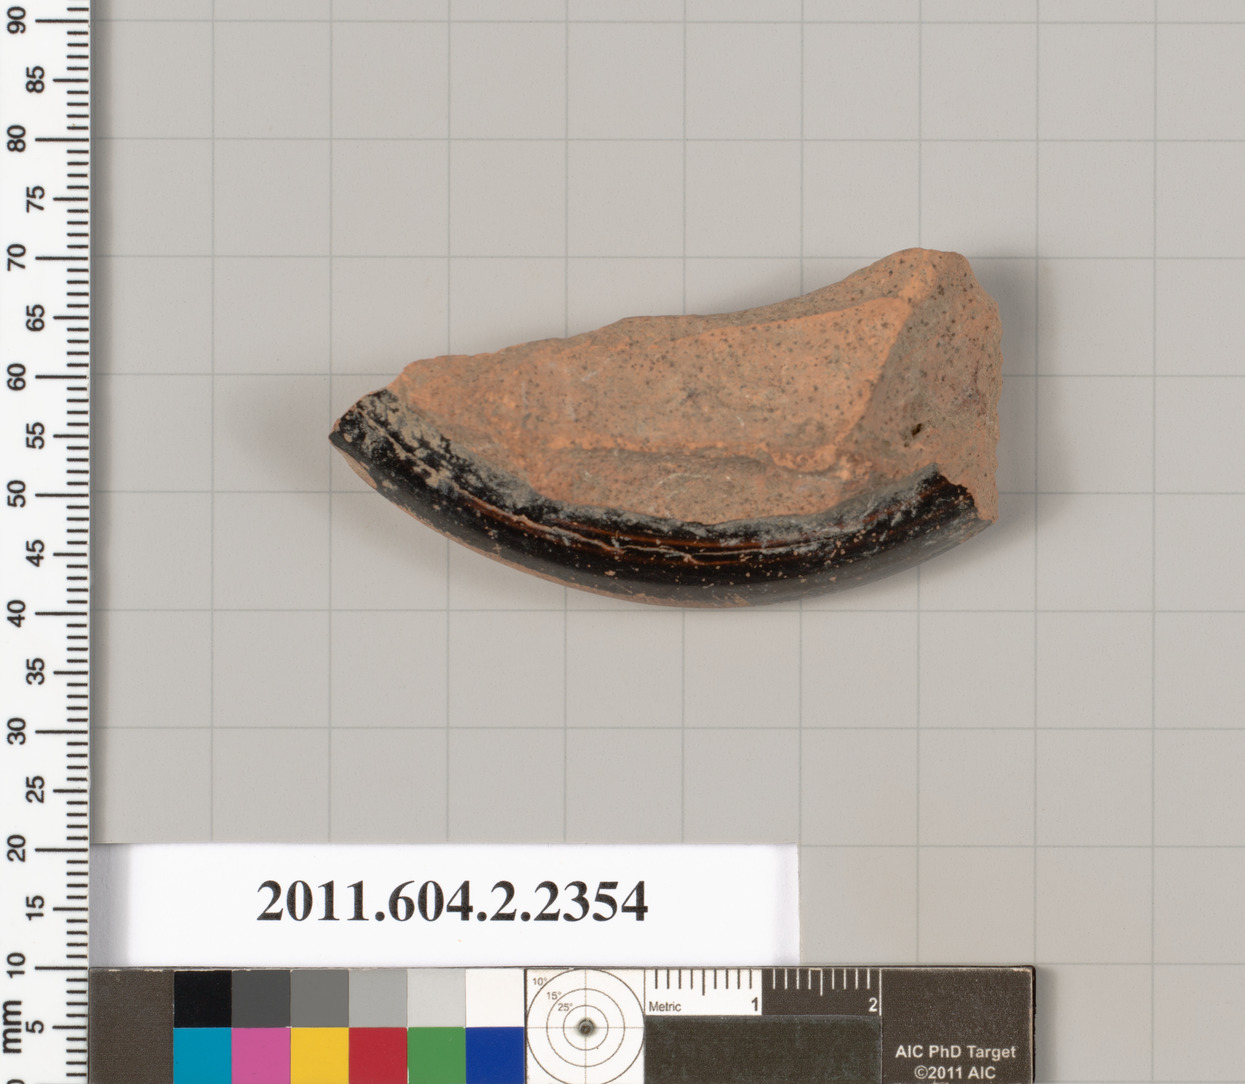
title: Terracotta fragment of an undetermined shape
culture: greek, attic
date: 600-401 BCE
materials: terracotta